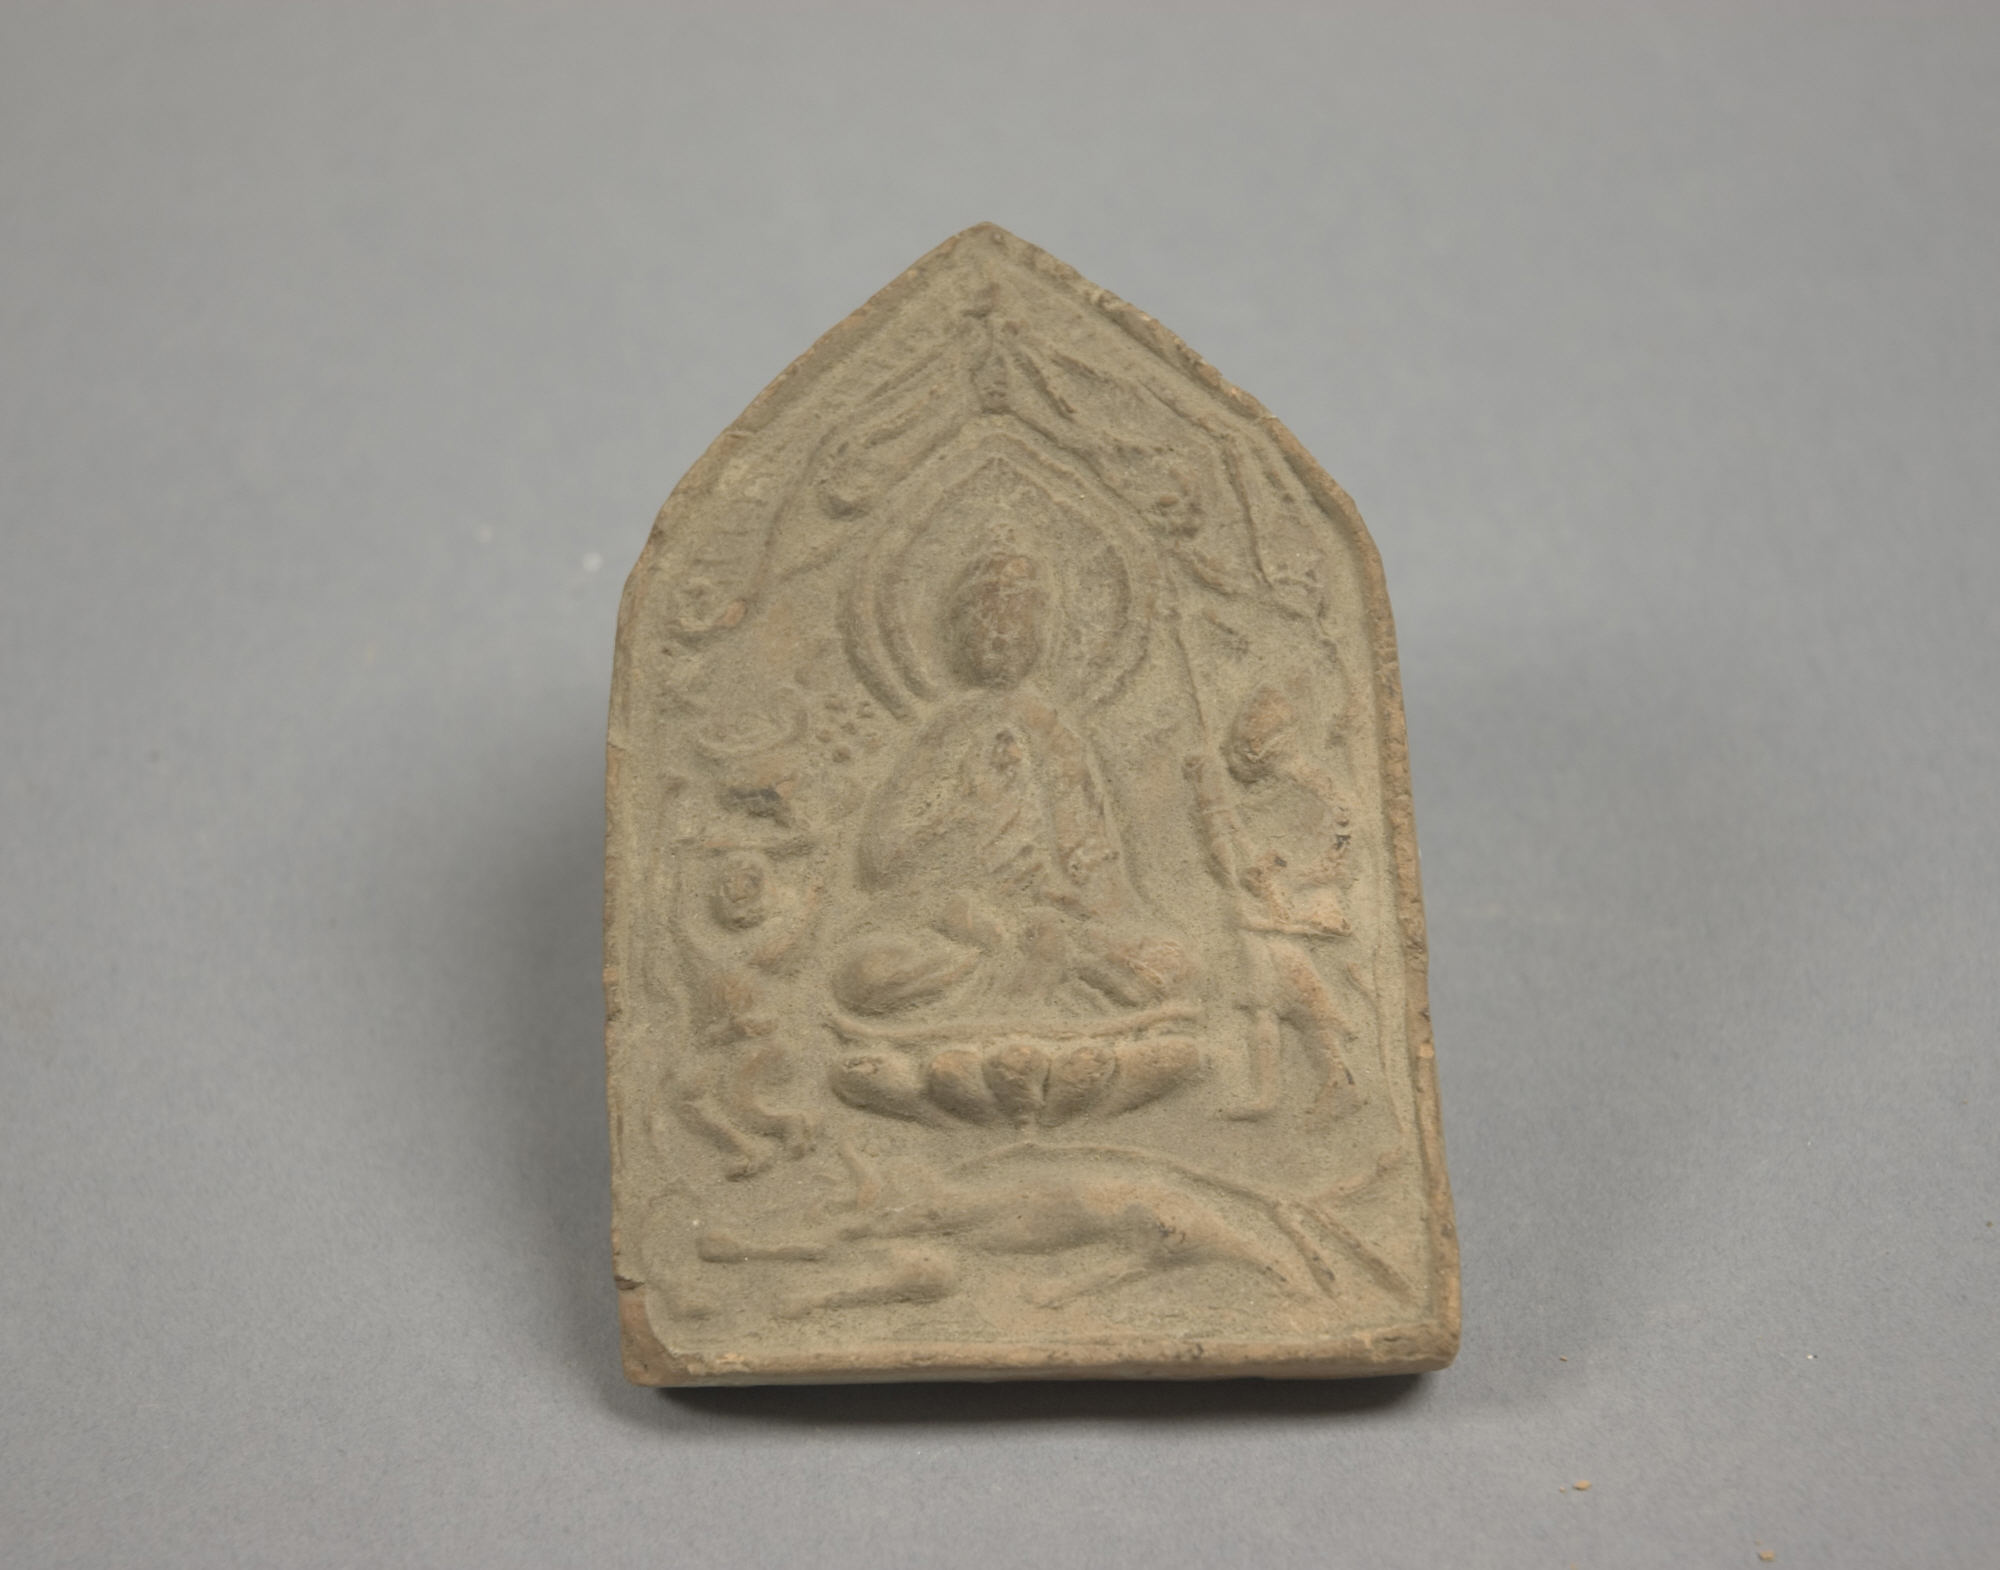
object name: votive tablet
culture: chinese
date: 501-600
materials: earthenware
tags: buddhism,buddha